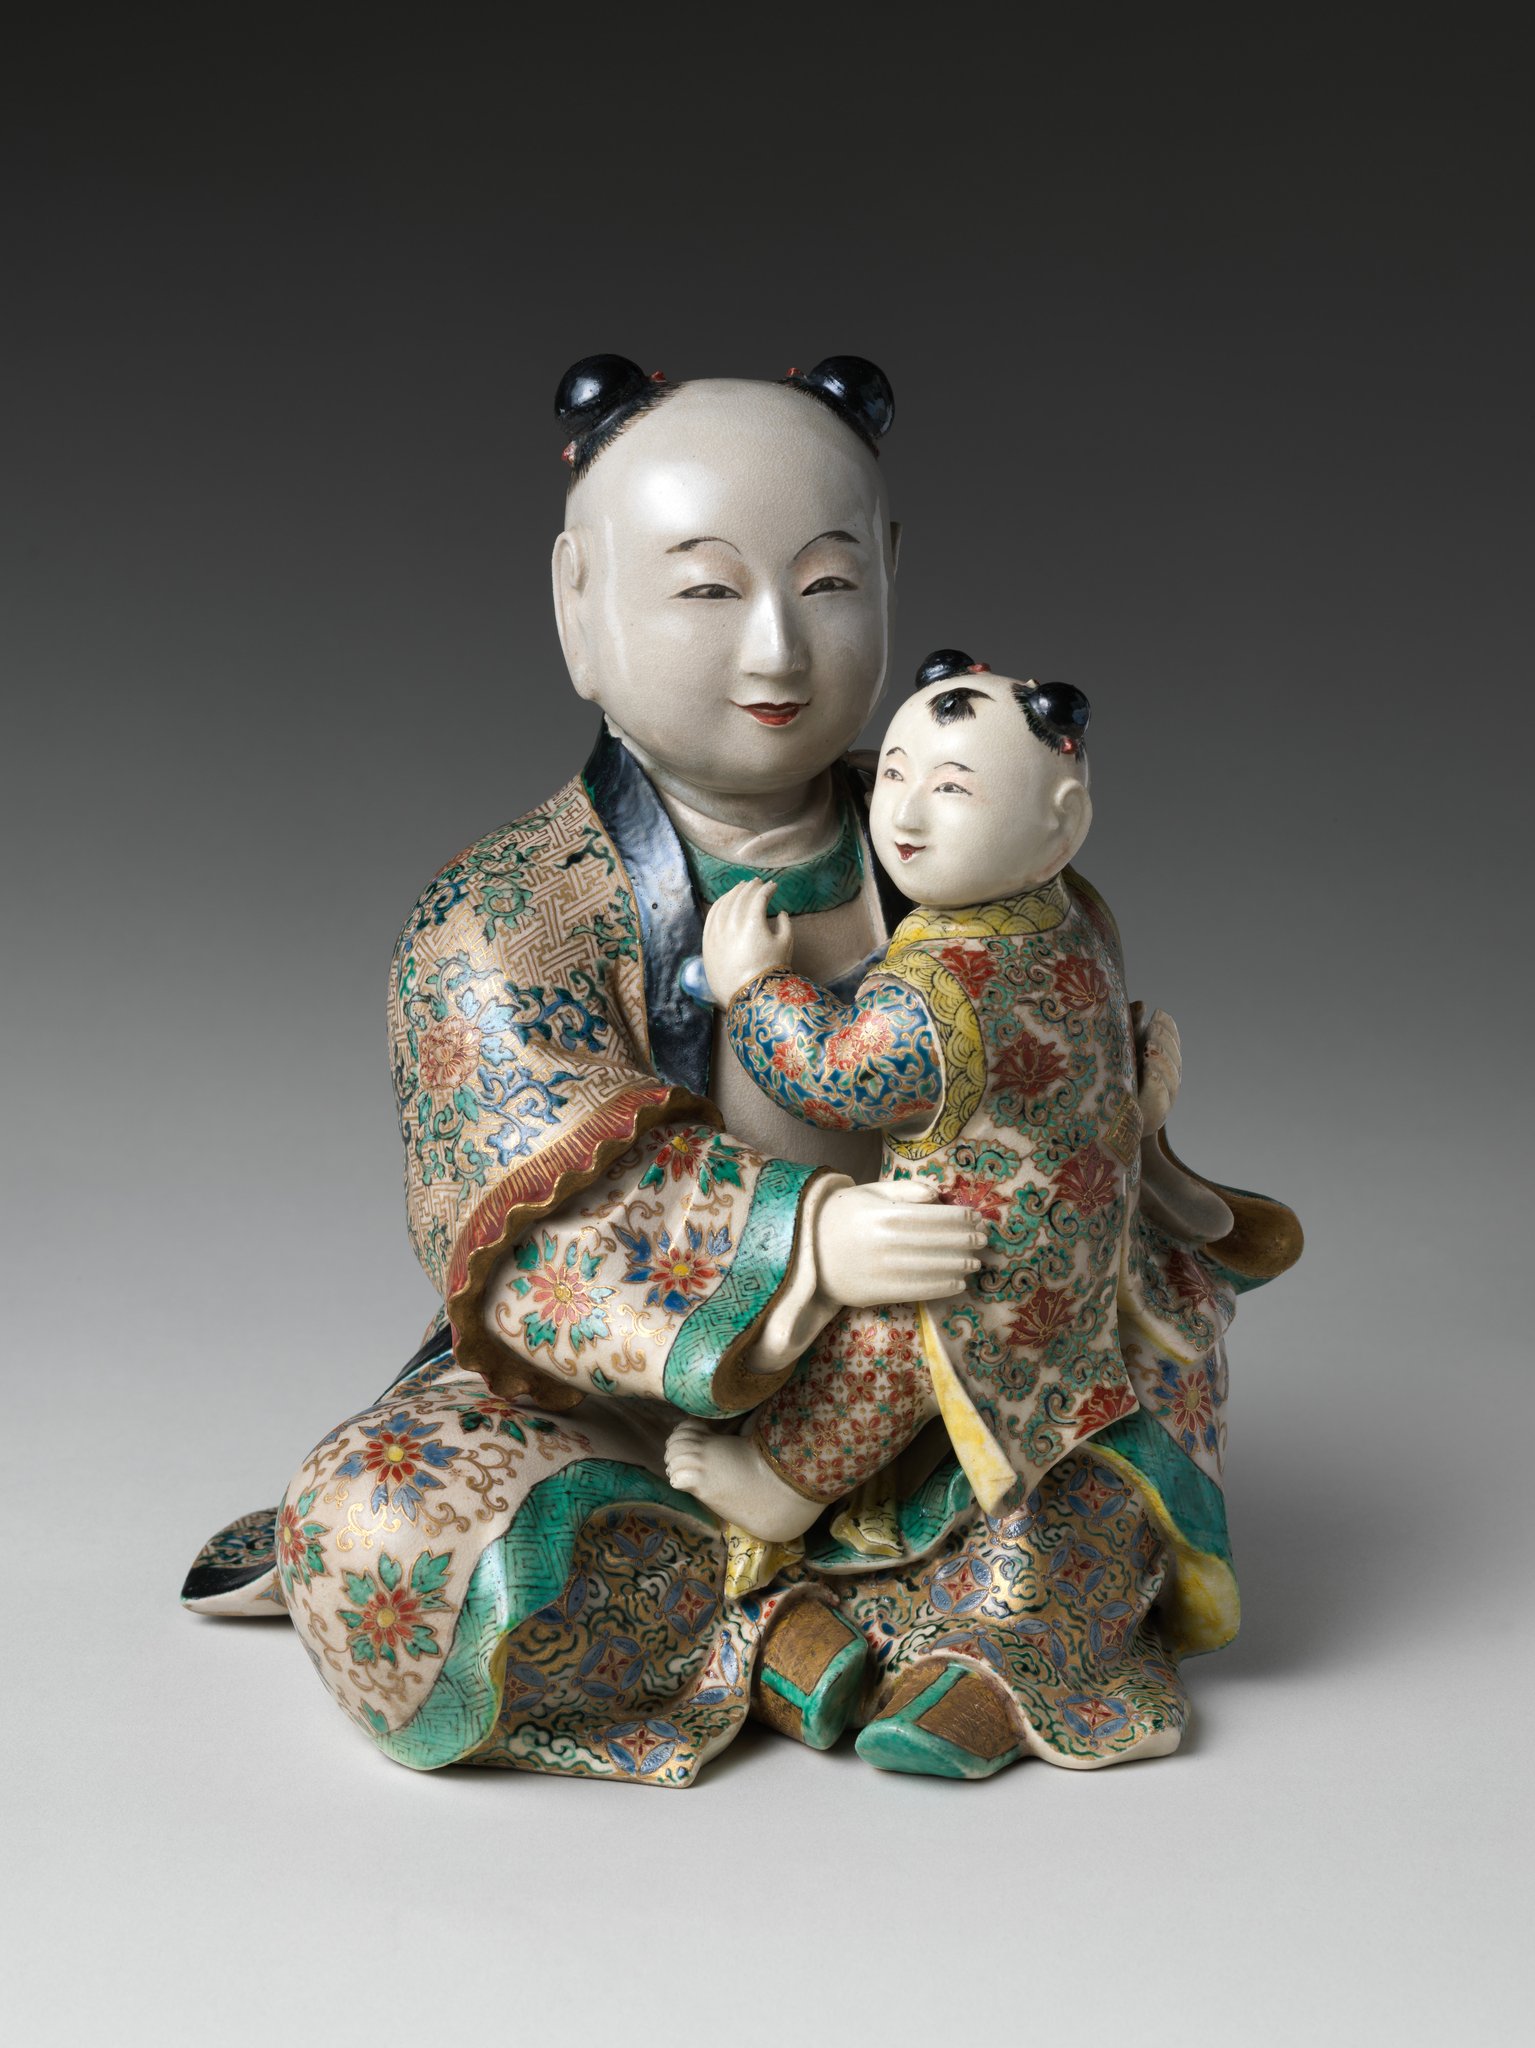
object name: figure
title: Seated Karako (Chinese boy) with a Child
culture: japanese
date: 1701-1833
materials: enamel, glaze, gold, stoneware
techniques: polychrome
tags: boys,infants